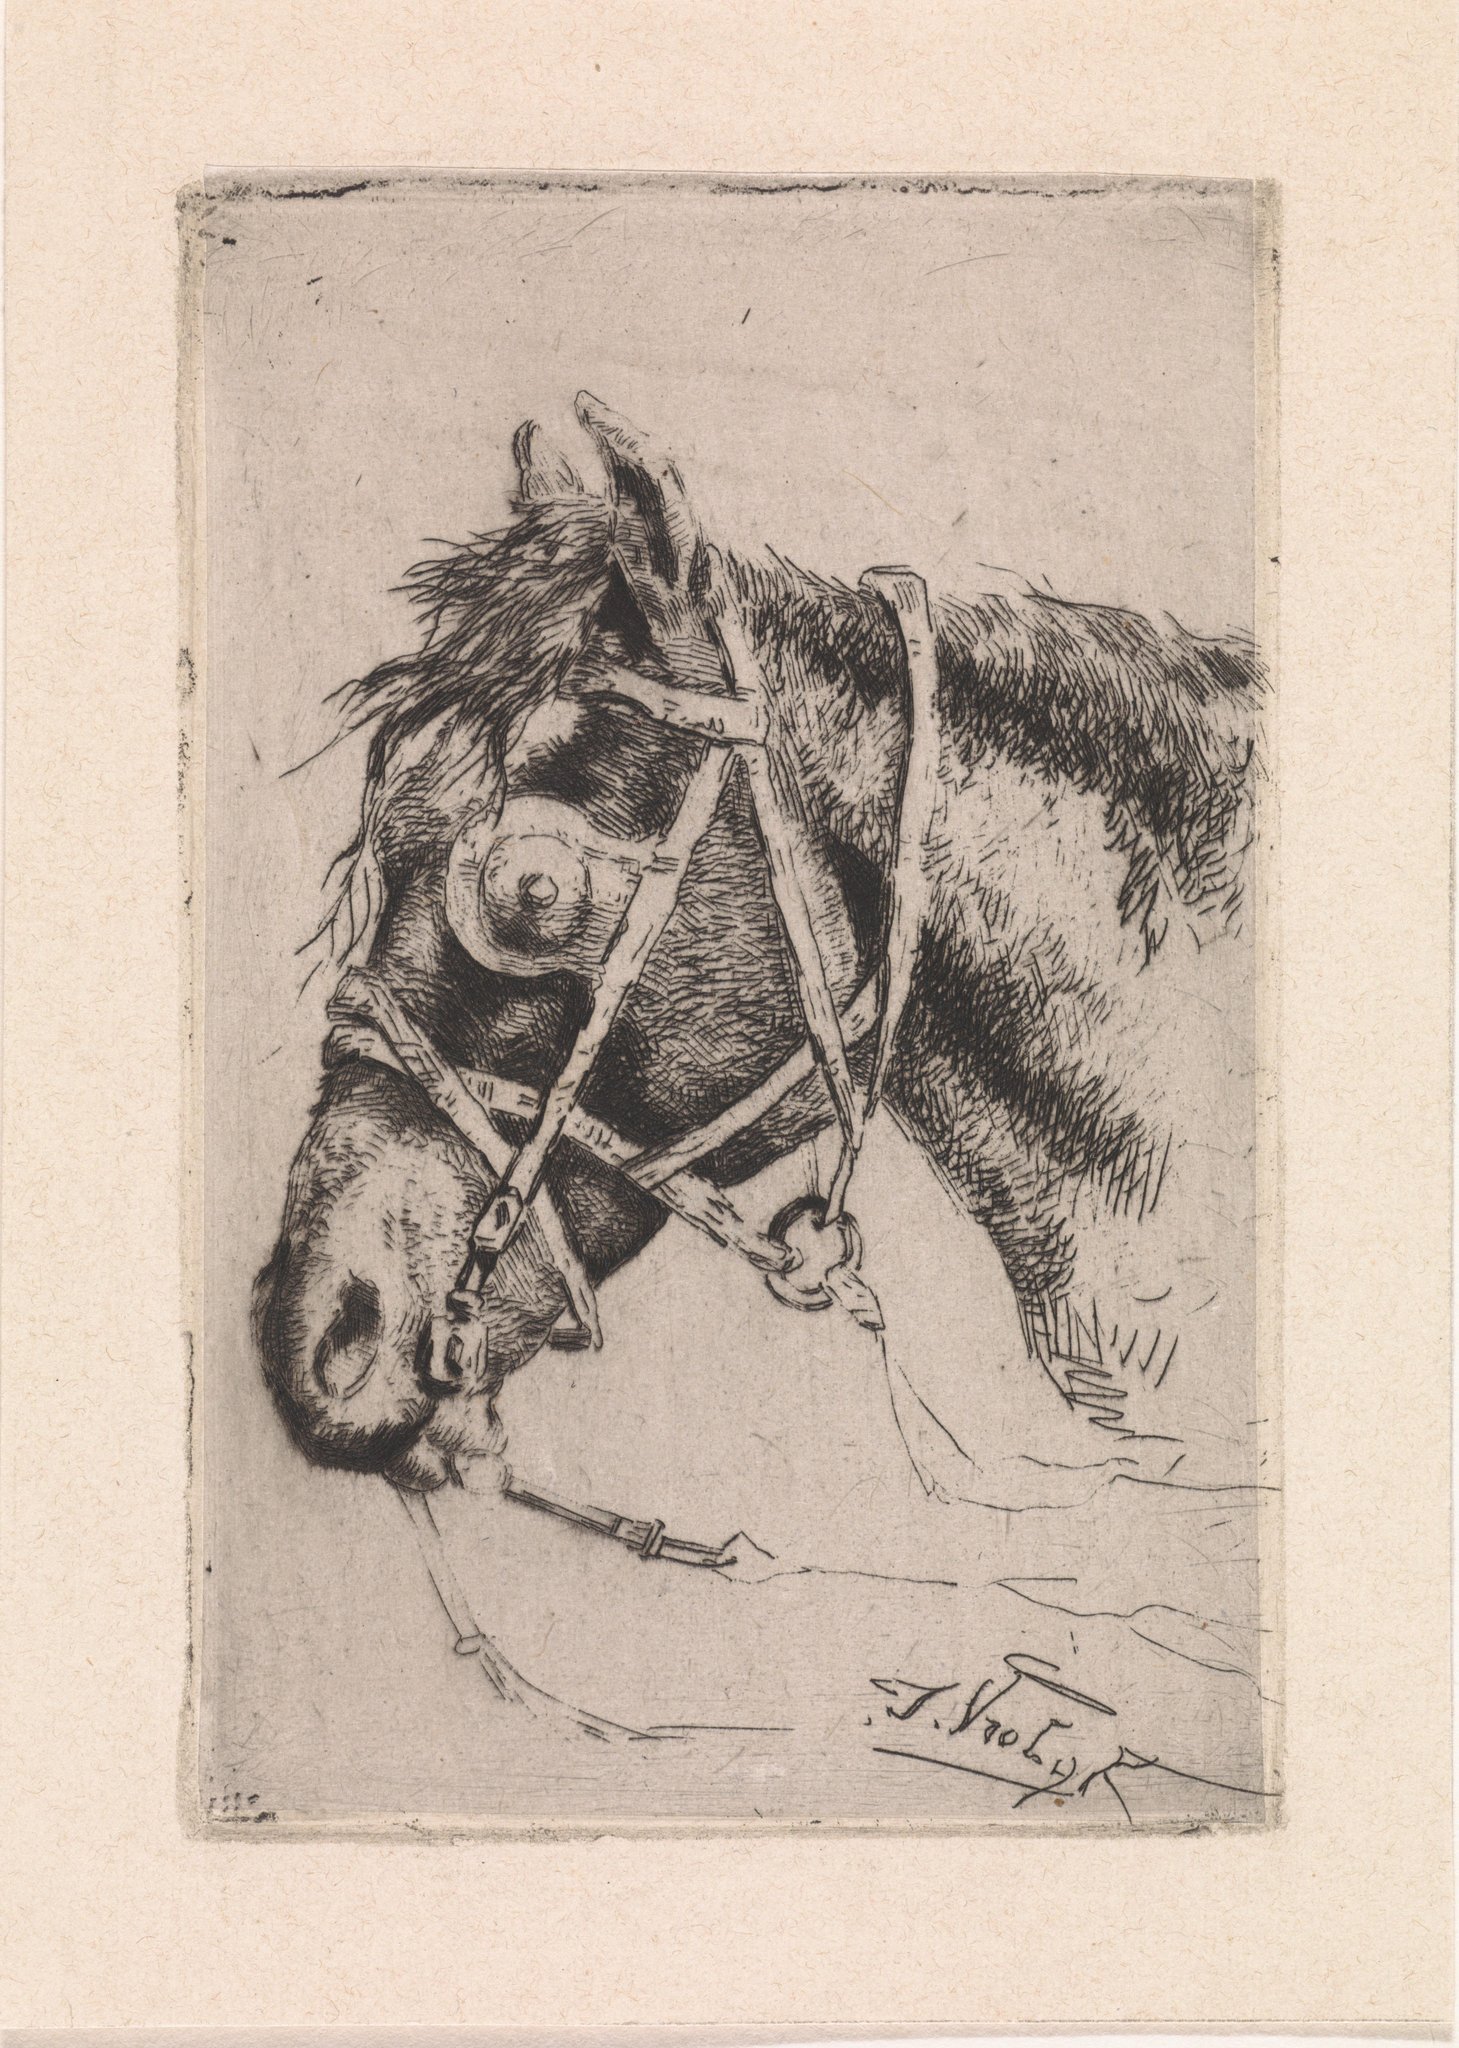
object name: print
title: Hoofd van een paard, met hoofdstel en oogkleppen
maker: jan vrolijk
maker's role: draughtsman, painter, print maker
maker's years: 1846-1894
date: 1856-1883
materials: paper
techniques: etching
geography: the hague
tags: horse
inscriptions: collector's mark: Lugt 2228